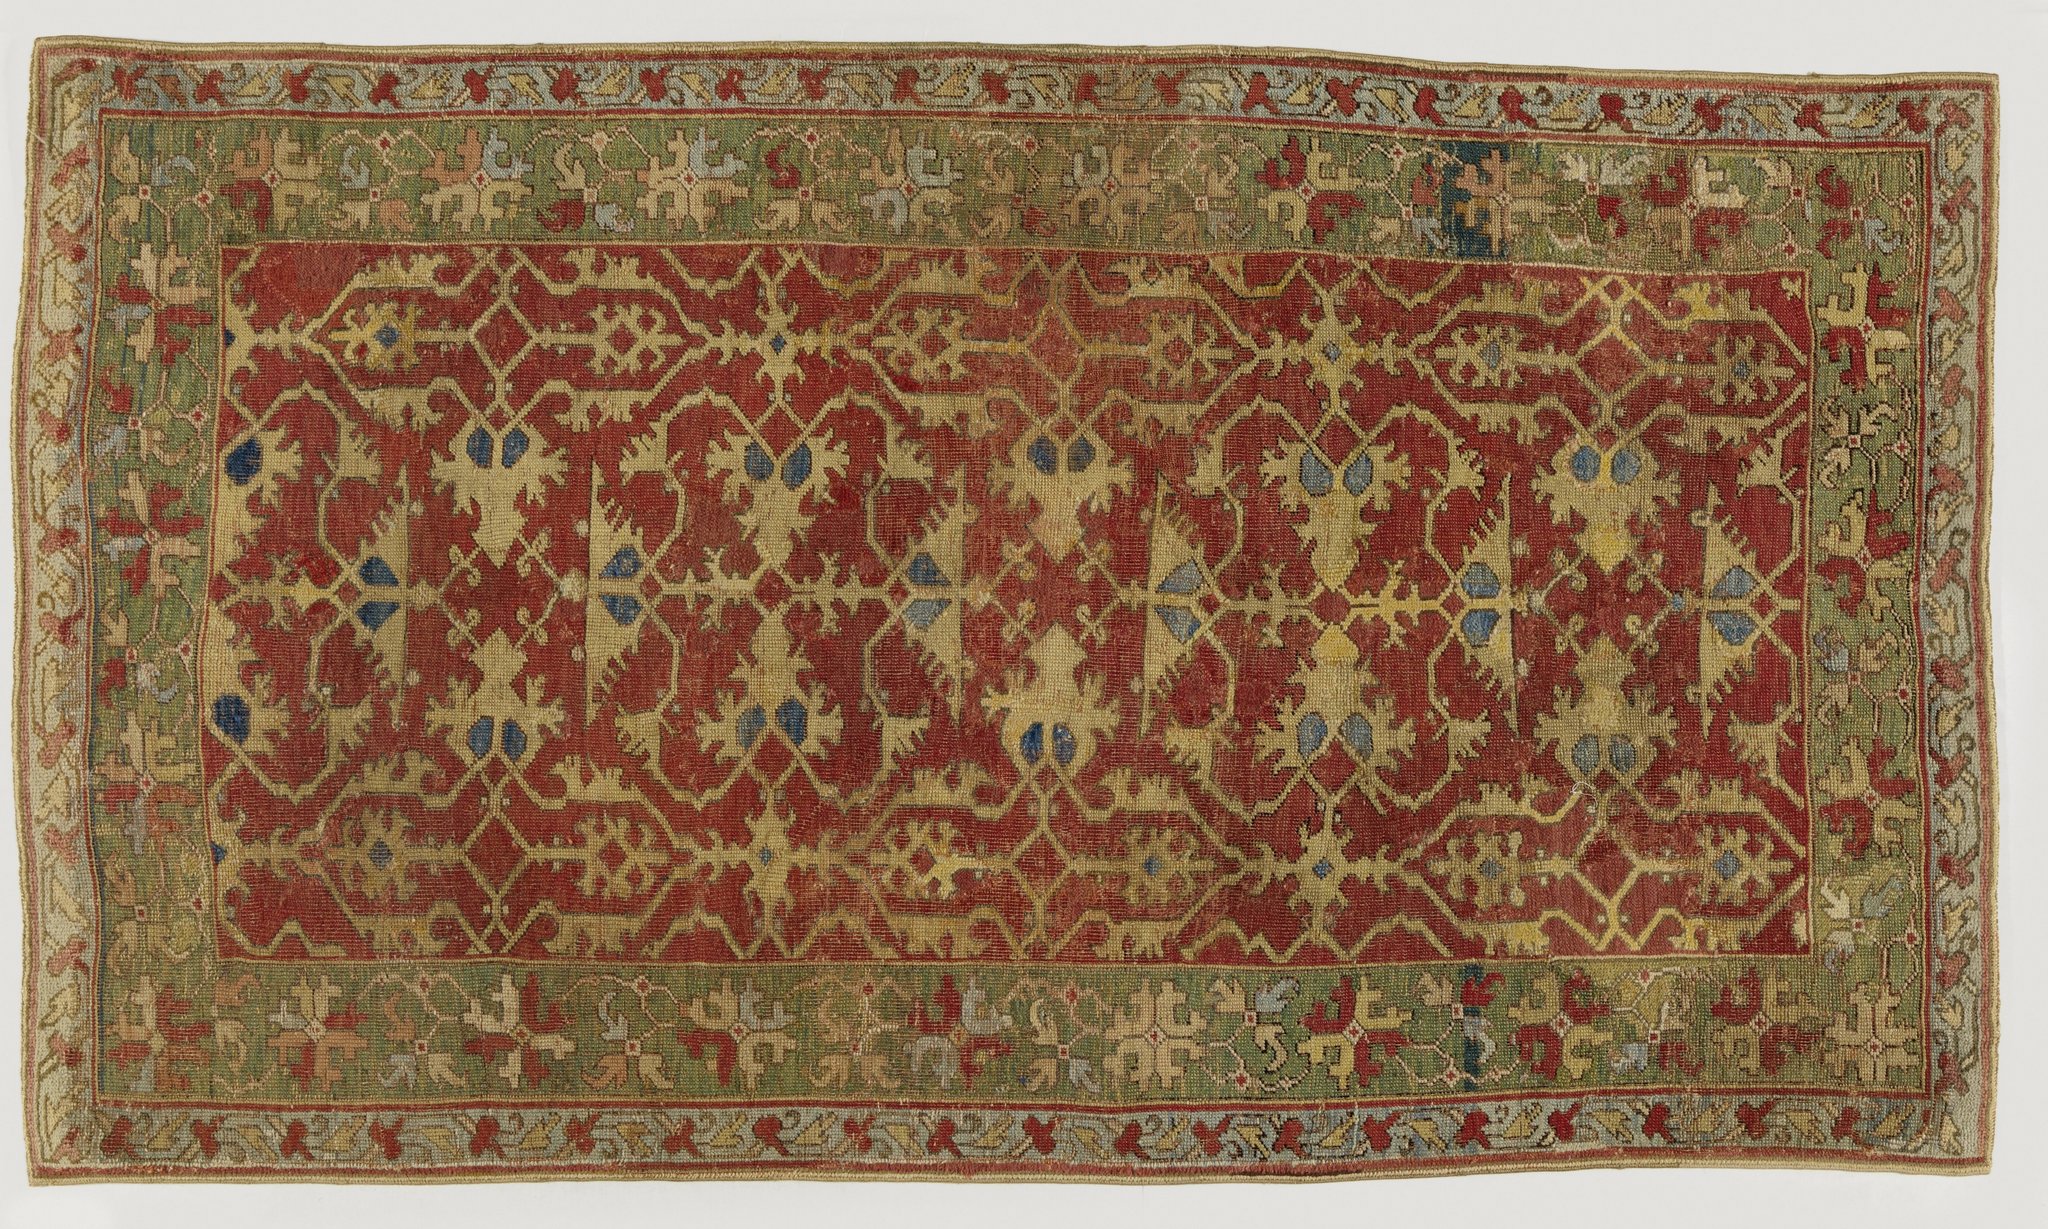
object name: tapijt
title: Tapijt, z.g. arabeskenkleed, met groene rand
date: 1590-1650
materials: wool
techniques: ghiordes knot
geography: asia minor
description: Arabeskenkleed met groene rand, Lotto tapijt. Middenveld met arabeskenmotieven. Tweevoudige rand. Knoop: Ghiordes knoop.